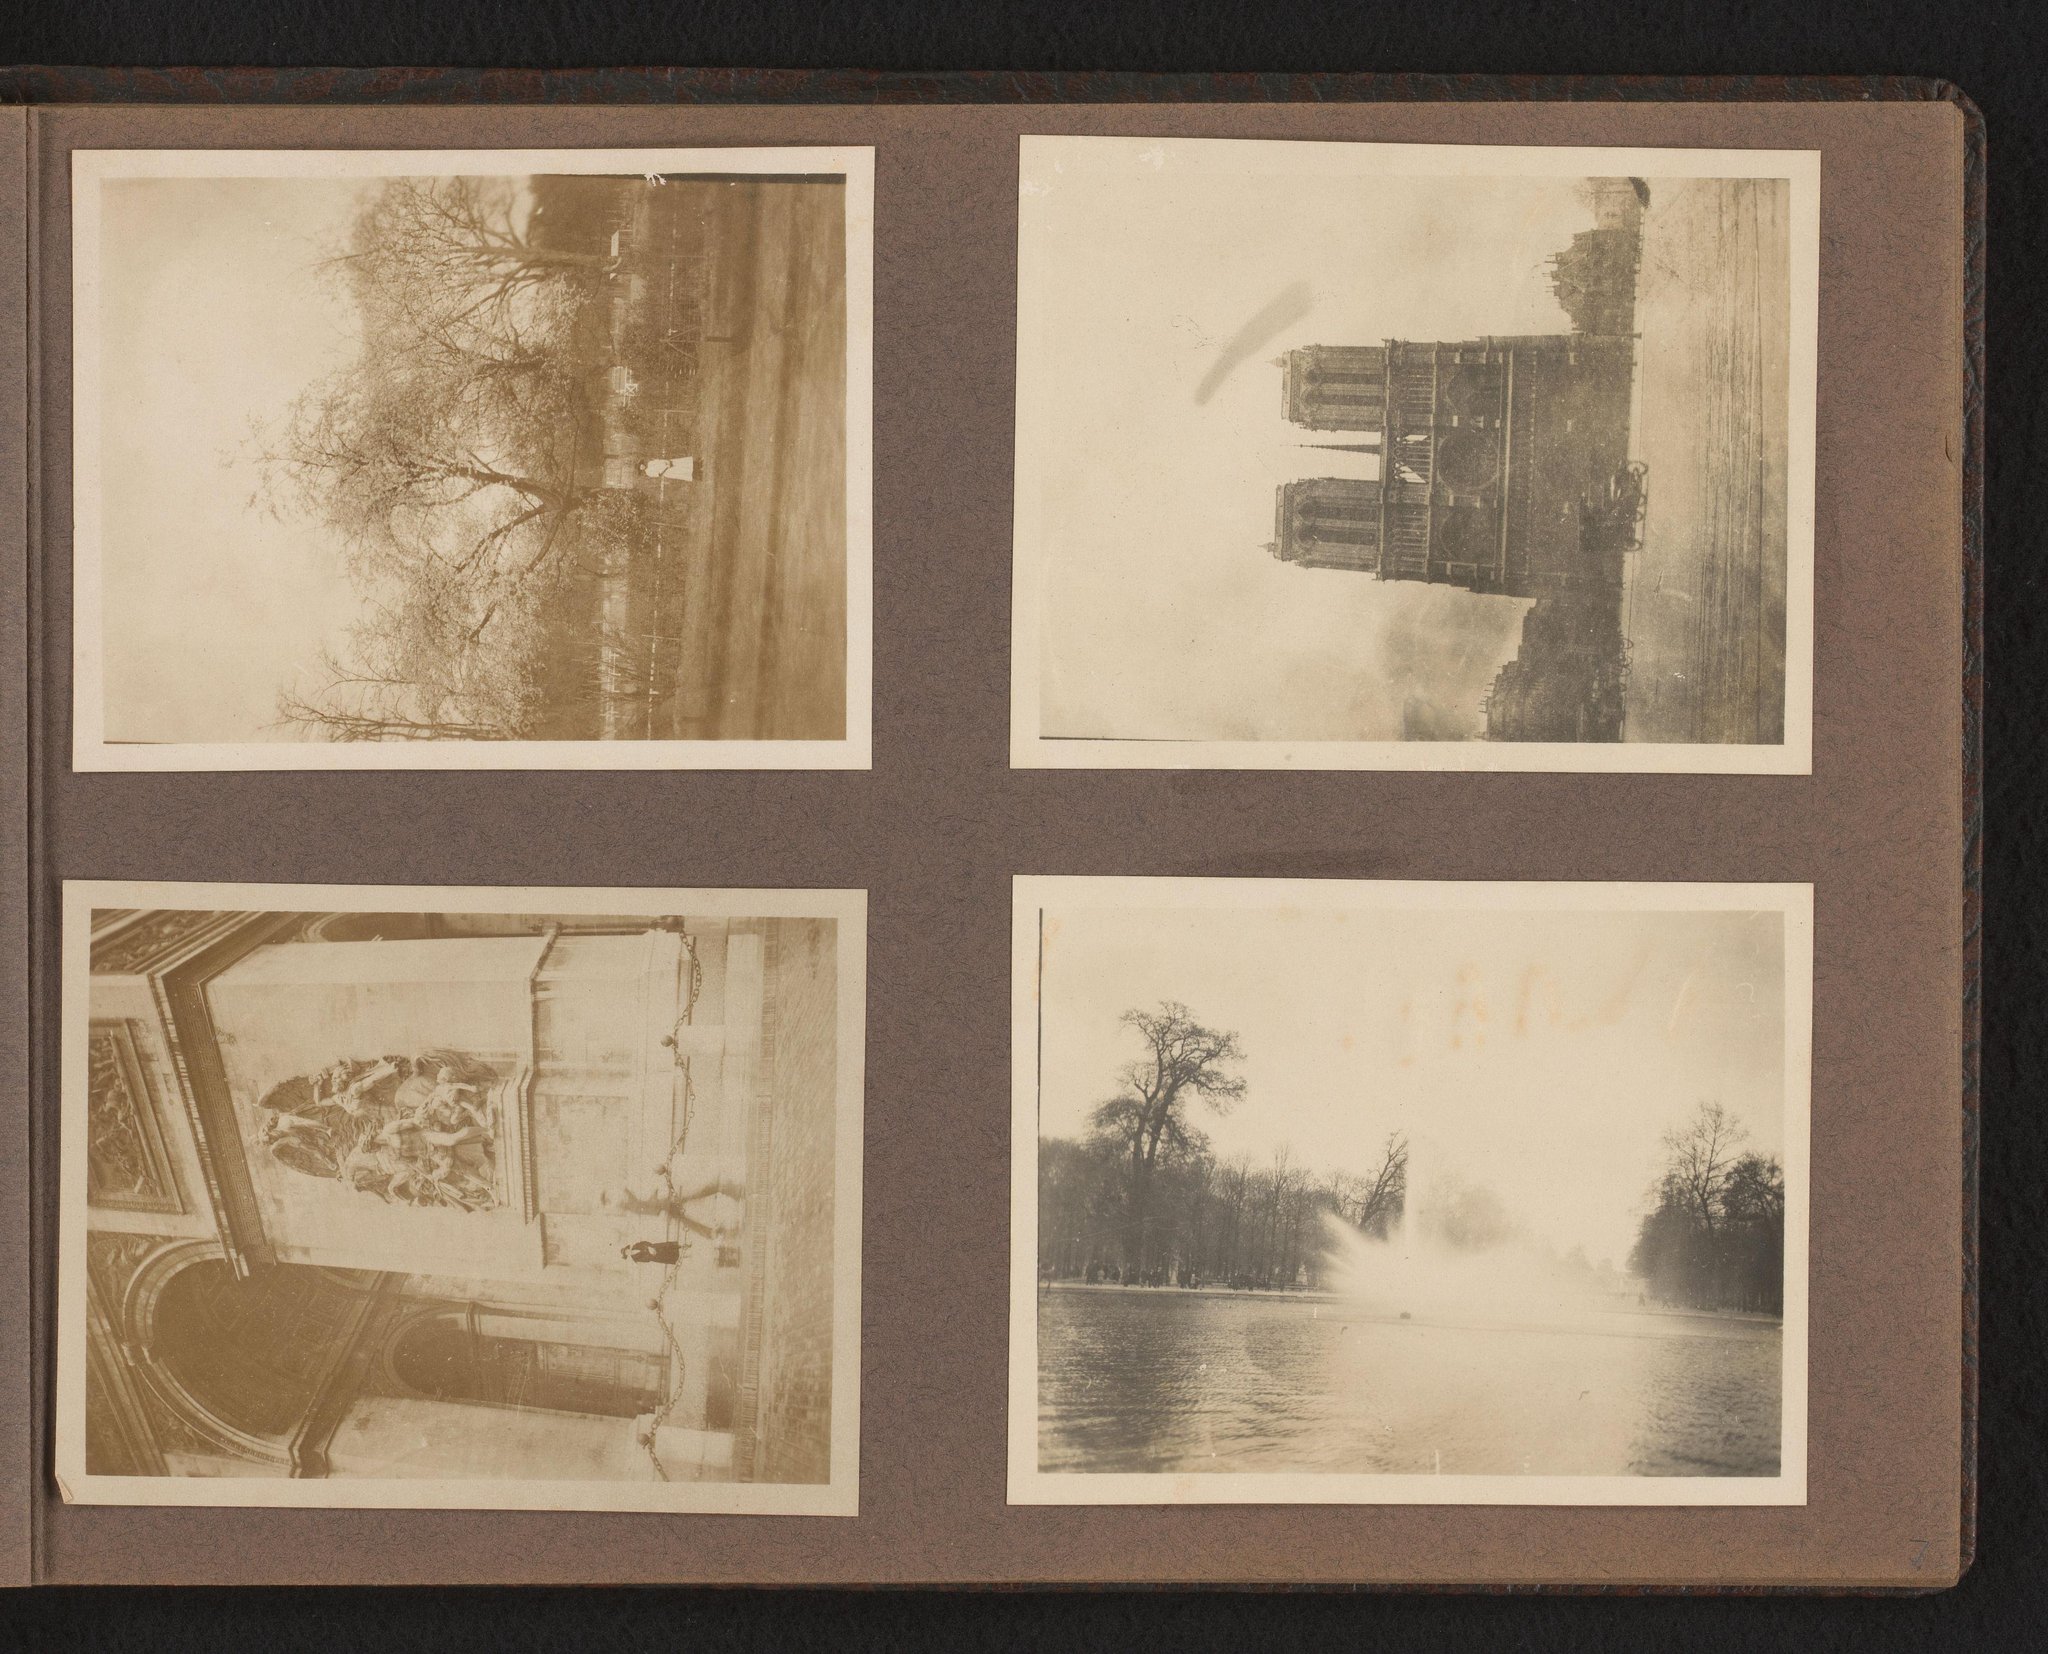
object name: photograph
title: Vier foto's te Parijs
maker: frédéric gabriël dumas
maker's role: engineer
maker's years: 1886-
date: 1919-1923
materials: cardboard, photographic support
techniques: gelatin silver print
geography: paris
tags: surabaya, engineer, frédéric gabriël dumas, beatrice jacqueline eveline dumas, java, outing, pleasure trip, paris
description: Blad met vier foto's van het bezoek aan Parijs. Onderdeel van een fotoalbum over de kindertijd van Eef Dumas met de familie op reis door Europa, ca. 1919-1923.